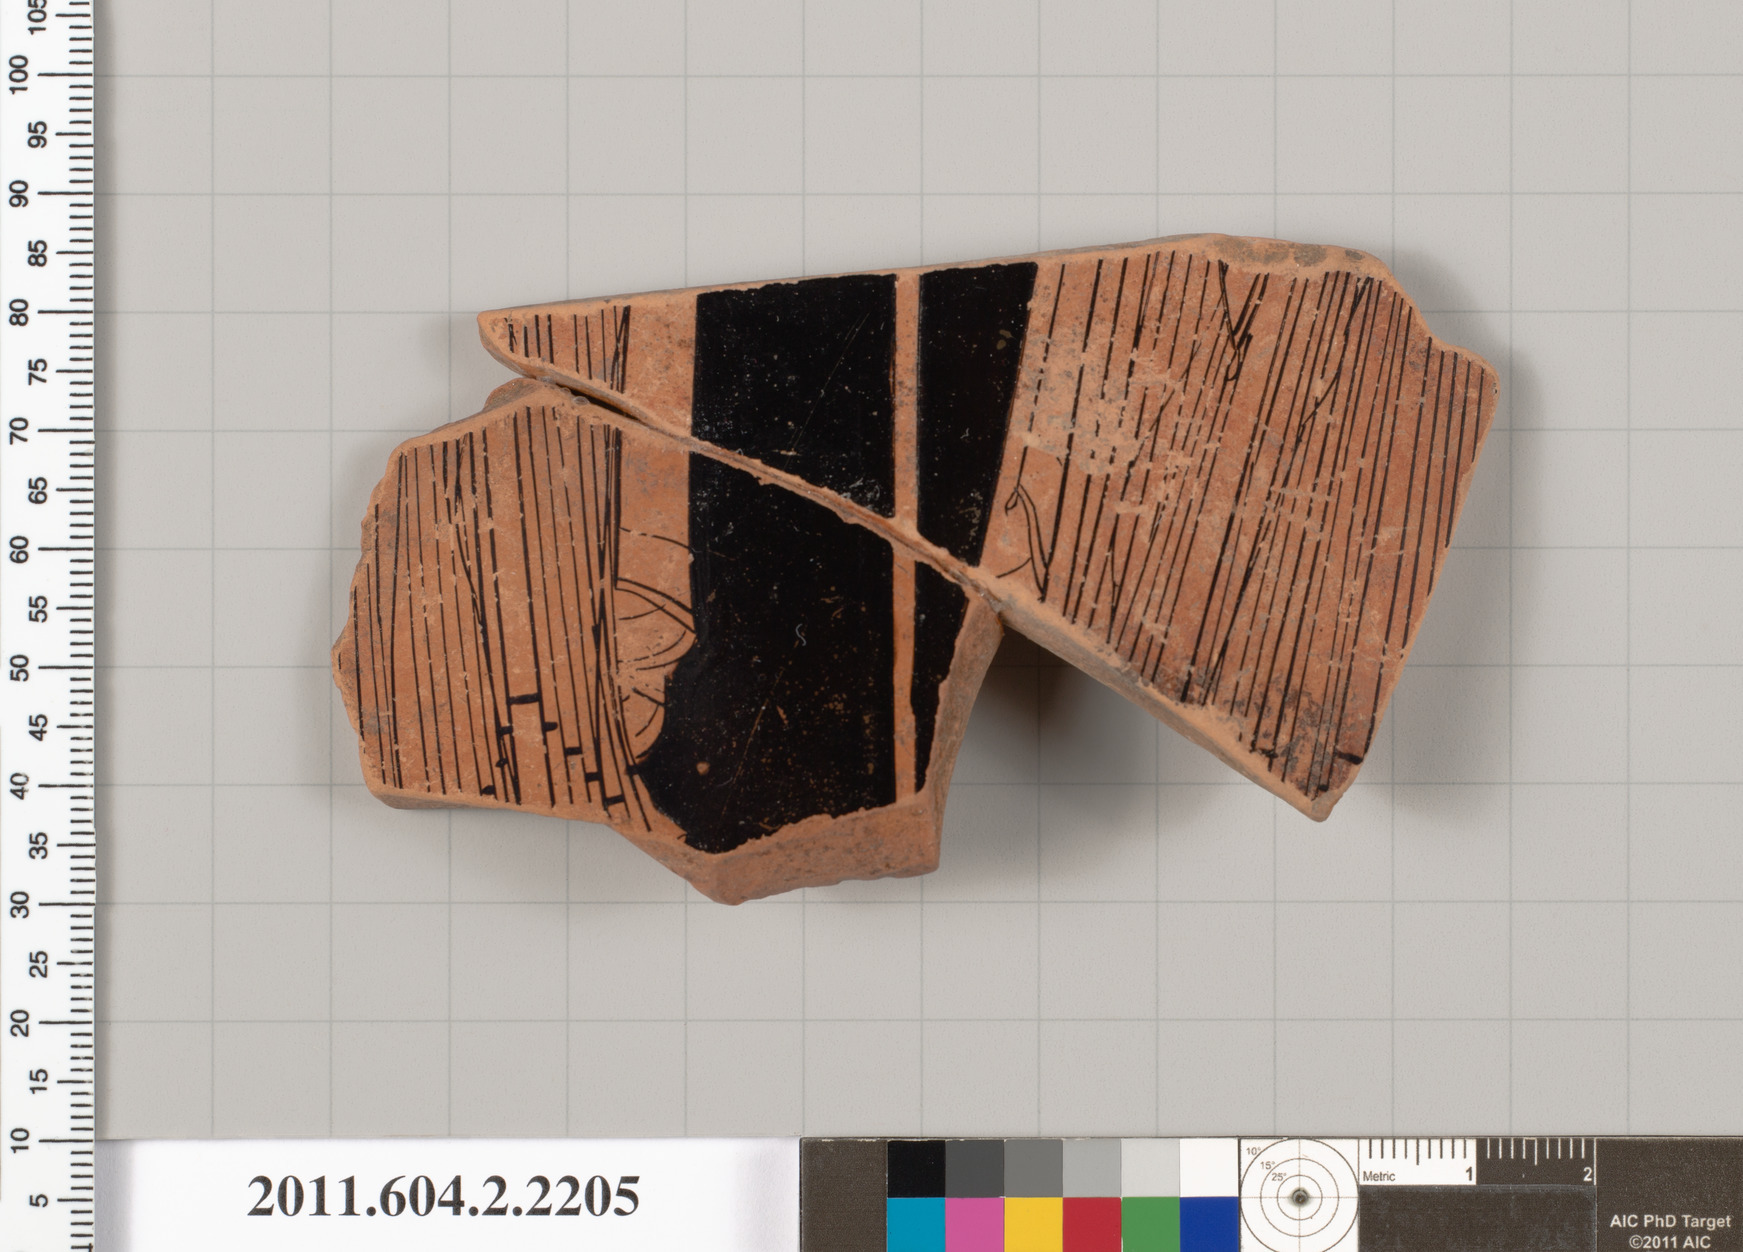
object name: pot fragment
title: Terracotta fragment of a pot; unglazed on the inside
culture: greek, attic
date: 475-451 BCE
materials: terracotta